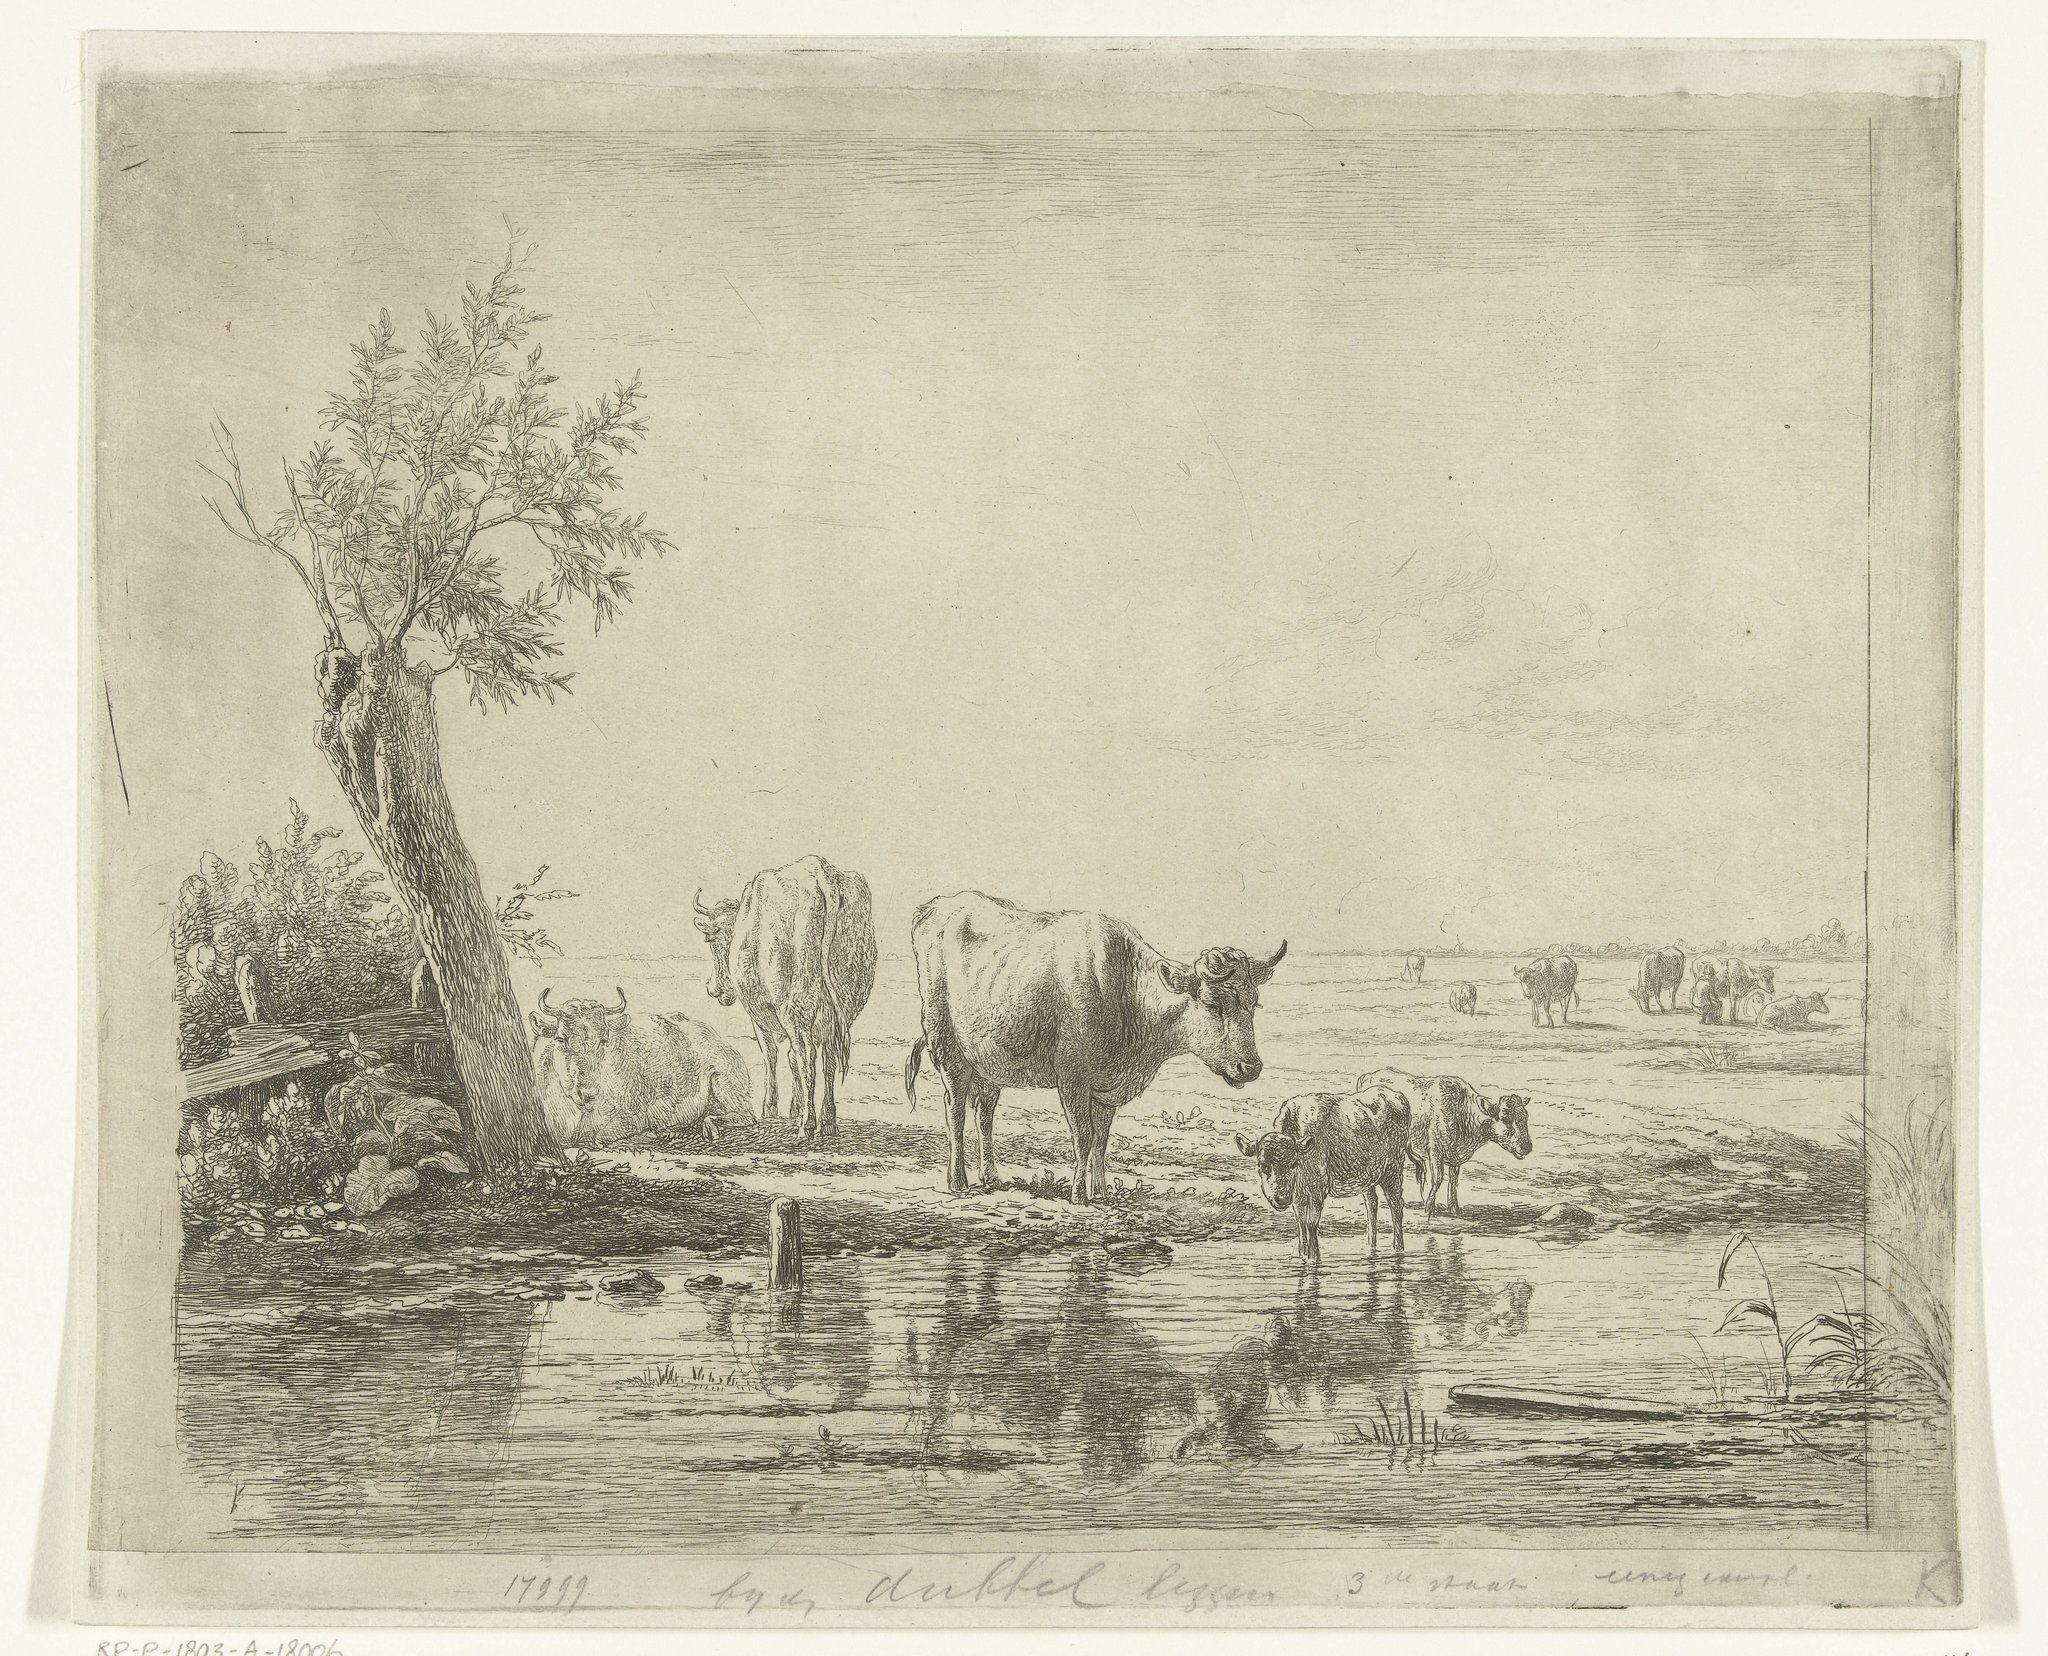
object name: print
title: Weidelandschap met koeien bij water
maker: simon van den berg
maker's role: draughtsman, print maker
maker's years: 1812-1891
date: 1822-1893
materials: paper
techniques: drypoint, etching, roulette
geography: netherlands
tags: cow, water meadows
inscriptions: collector's mark: Lugt 698, collector's mark: Lugt 2228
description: Op verso nog een afgewezen druk van de vierde staat.